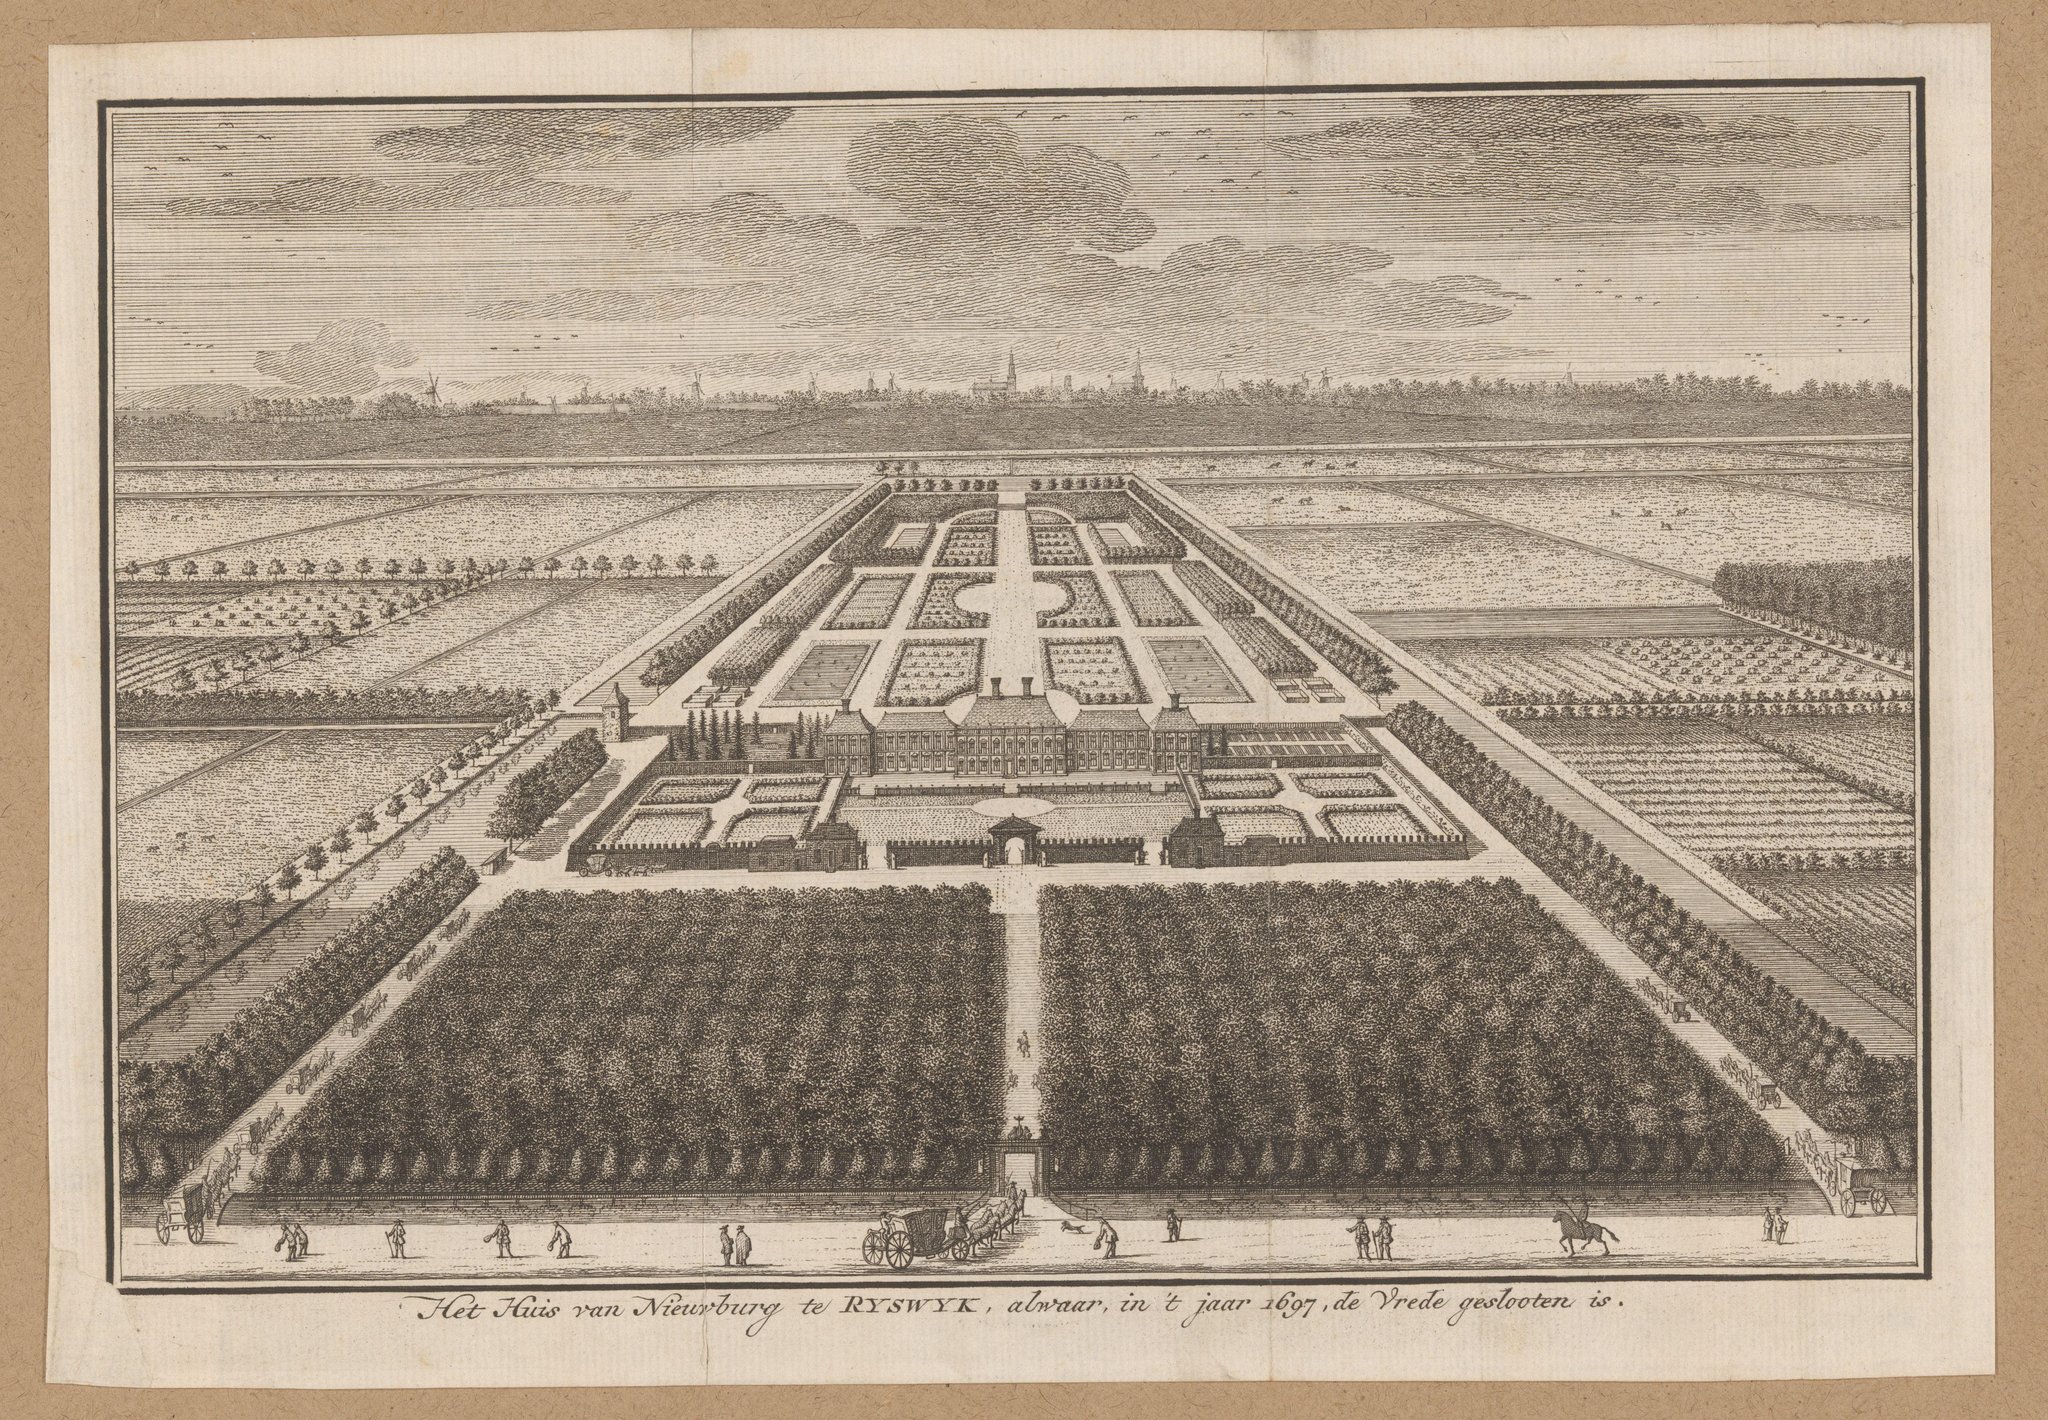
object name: print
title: Gezichten op Huis Ter Nieuburch in Rijswijk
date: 1757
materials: paper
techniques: engraving, etching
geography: amsterdam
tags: castle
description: Prent uit: Wagenaar, Jan. Vaderlandsche historie, vervattende de geschiedenissen der Vereenigde Nederlanden (...). 21 dln. Amsterdam: Isaak Tirion, 1749-1759, dl. 16 (1757), p. 348-349.